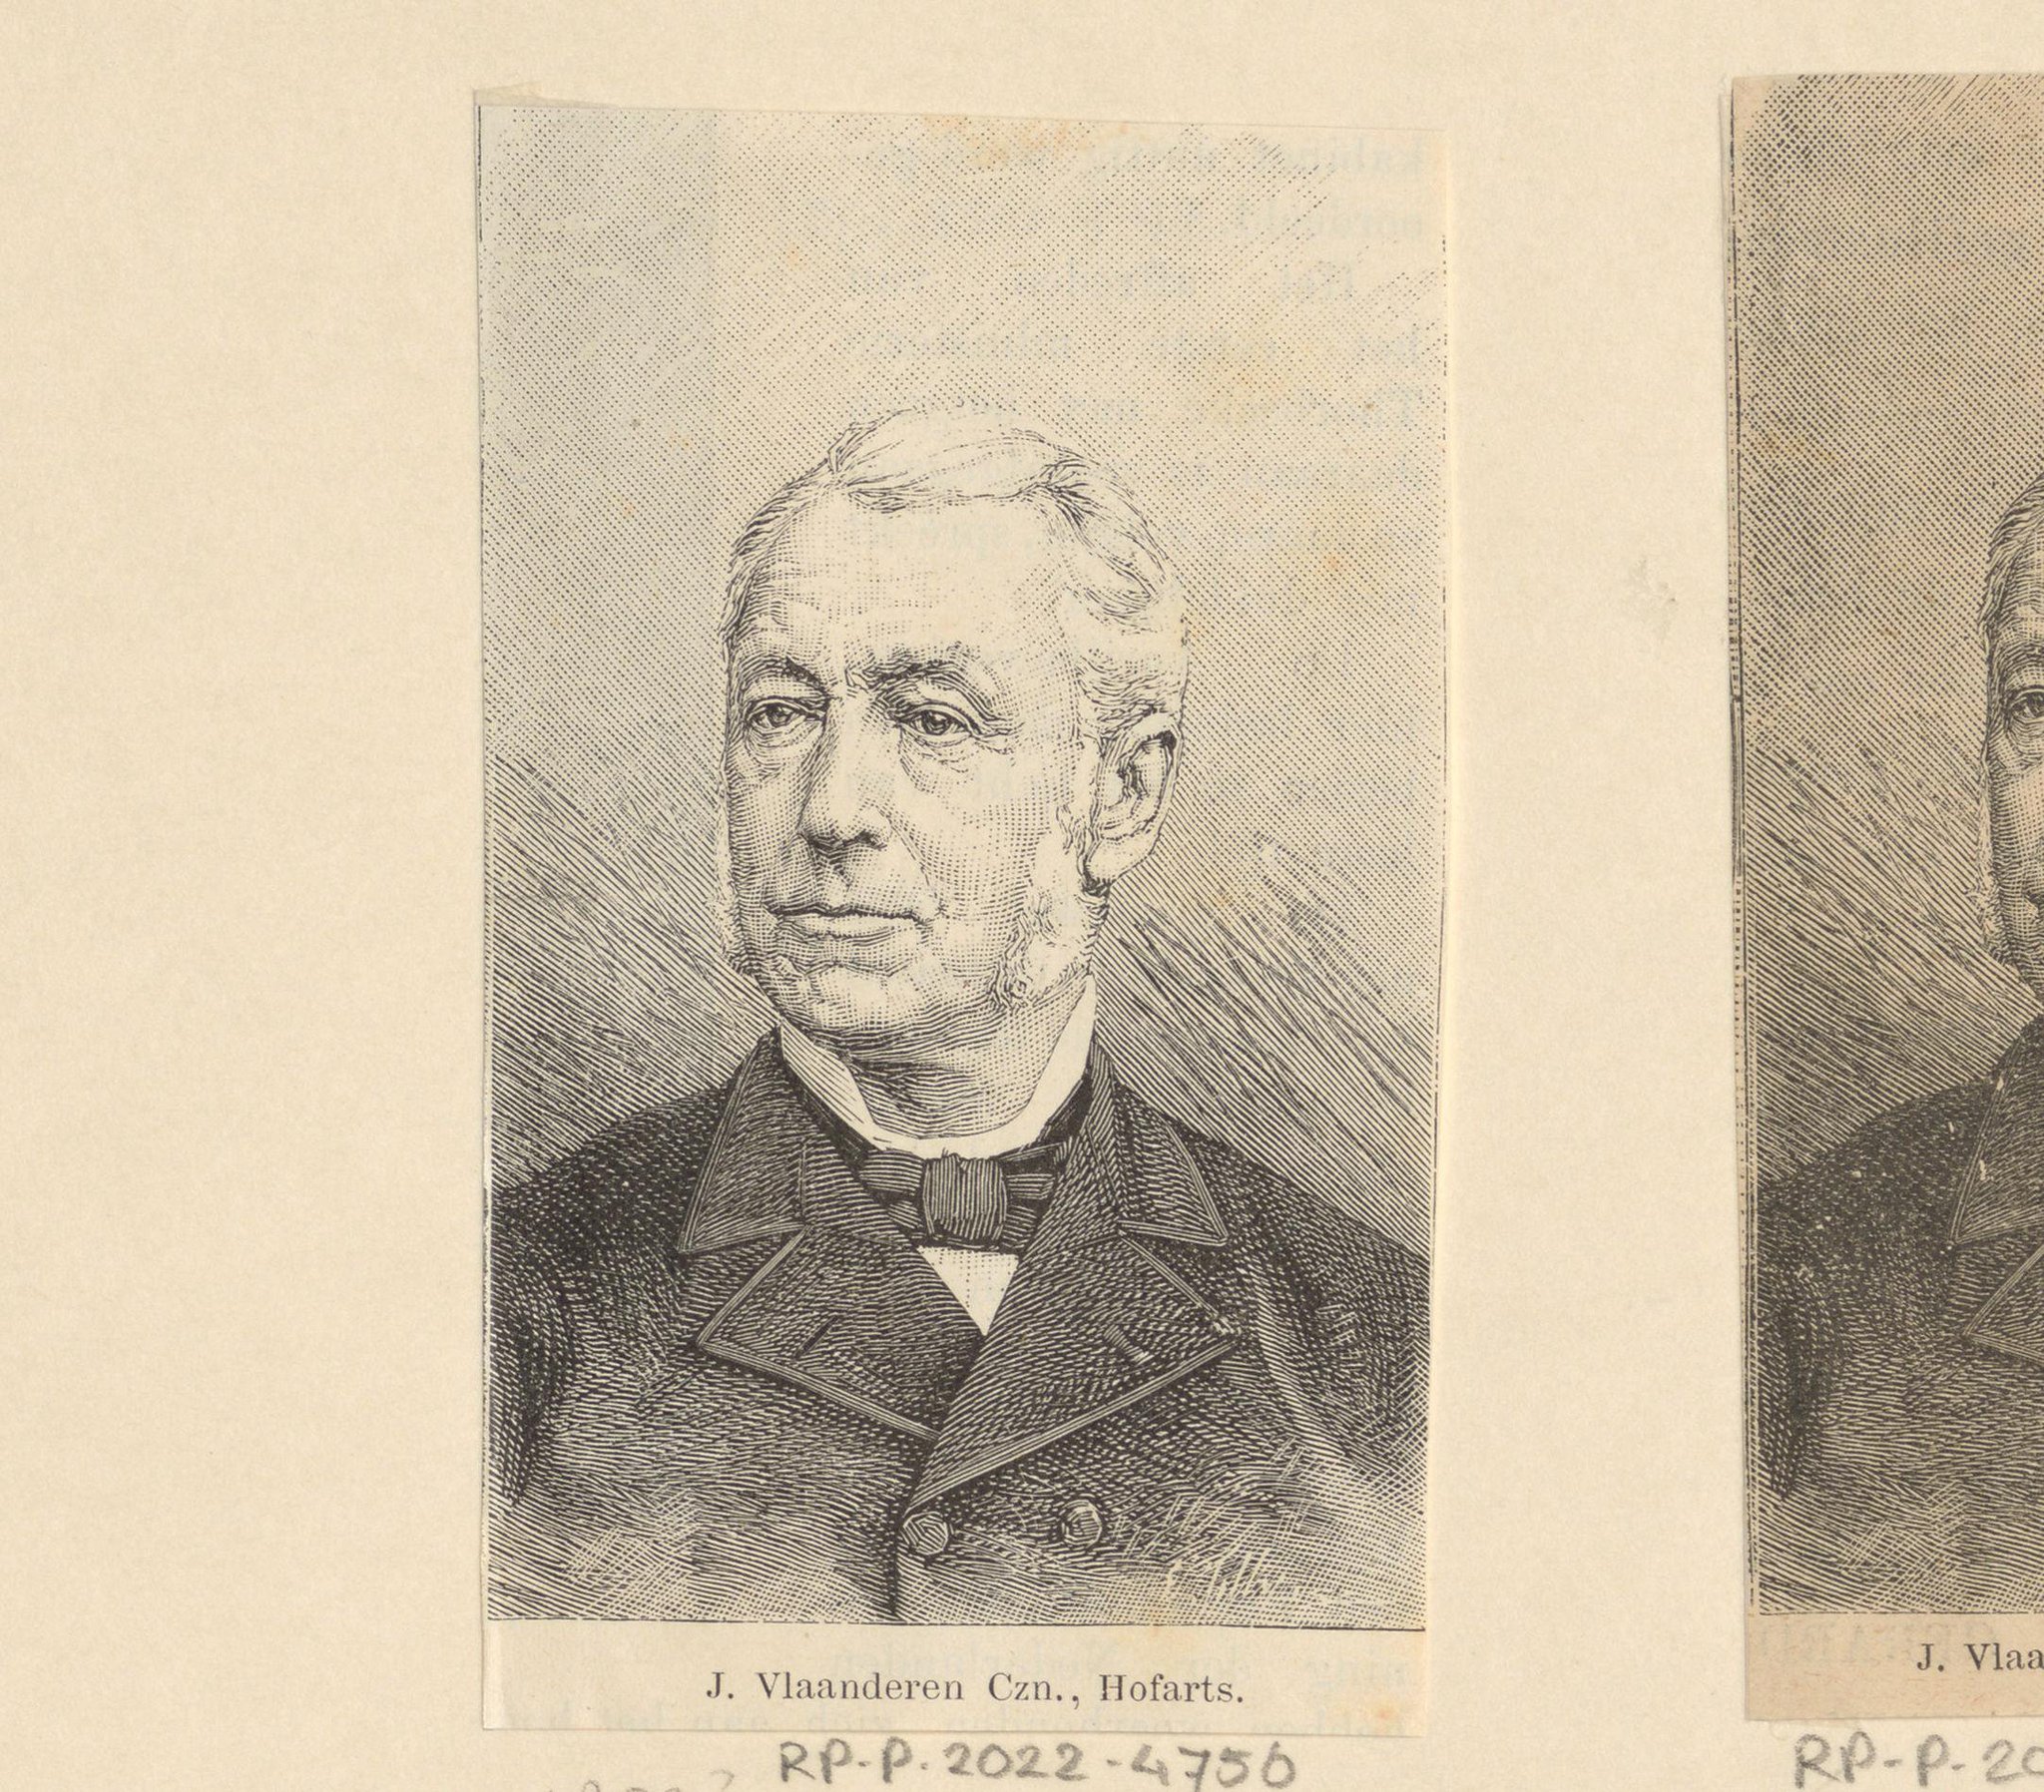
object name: print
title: Portret van J. Vlaanderen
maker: Anonymous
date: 1890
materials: paper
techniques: letterpress printing, engraving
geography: netherlands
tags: historical persons, physician, doctor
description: Prent uit: Eigen Haard (1890), nr. 43, p. 764.